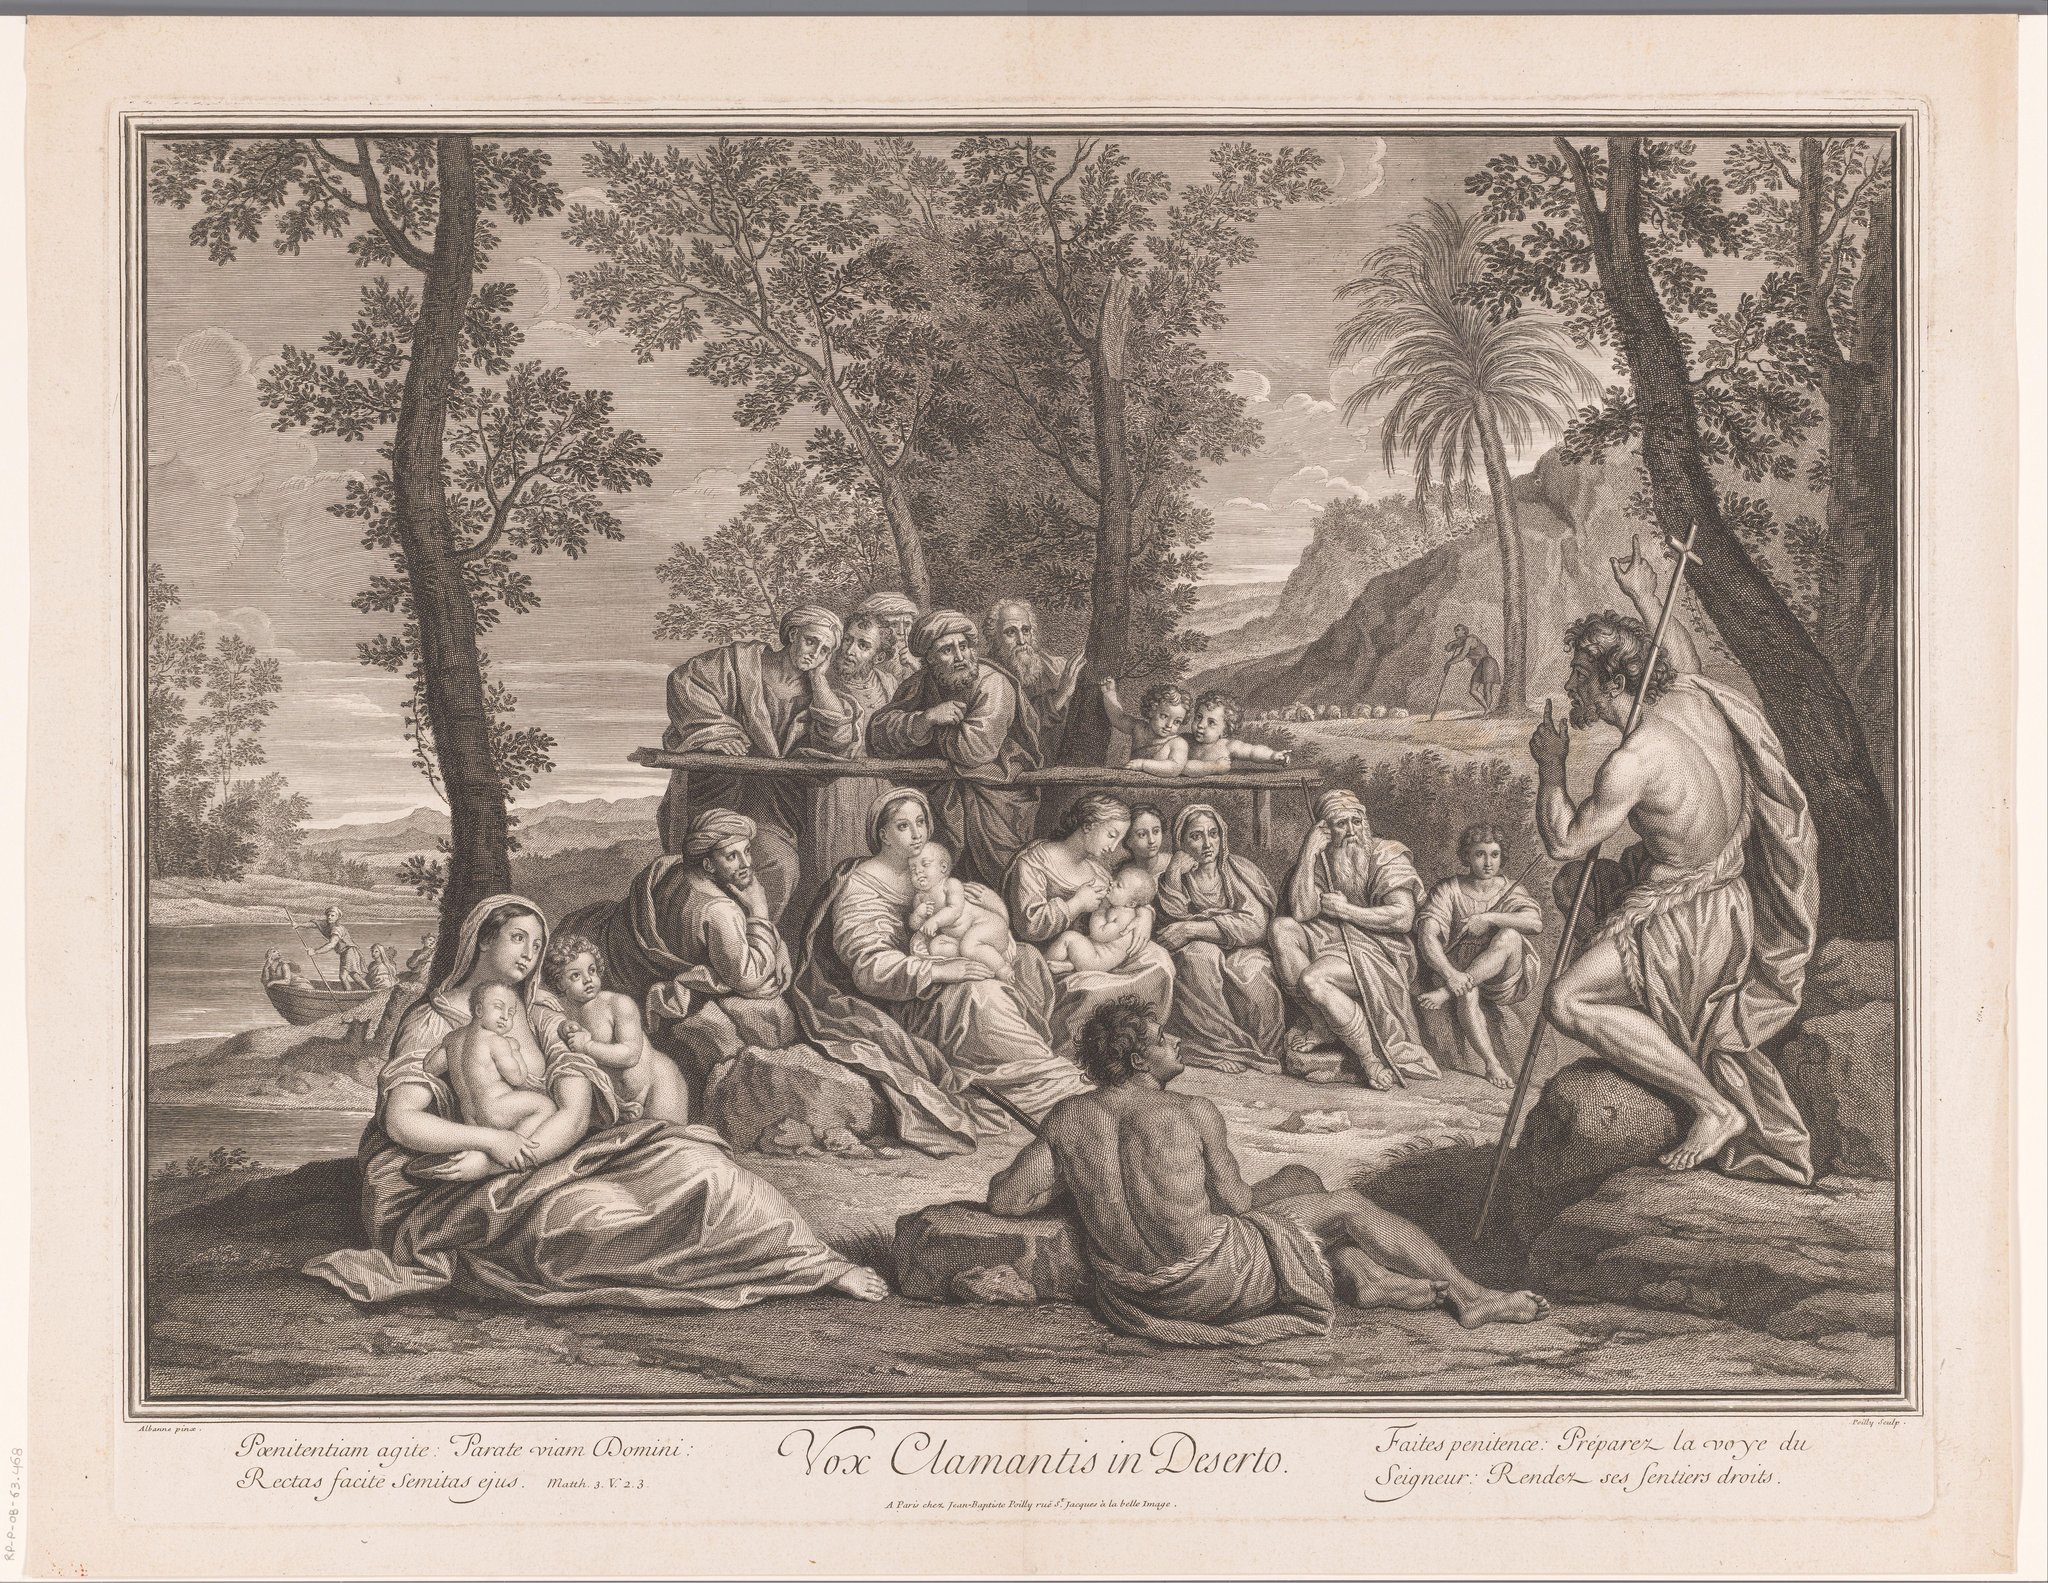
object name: print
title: Prediking van Johannes de Doper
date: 1679-1728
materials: paper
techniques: etching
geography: paris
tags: john preaching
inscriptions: collector's mark: Lugt 240